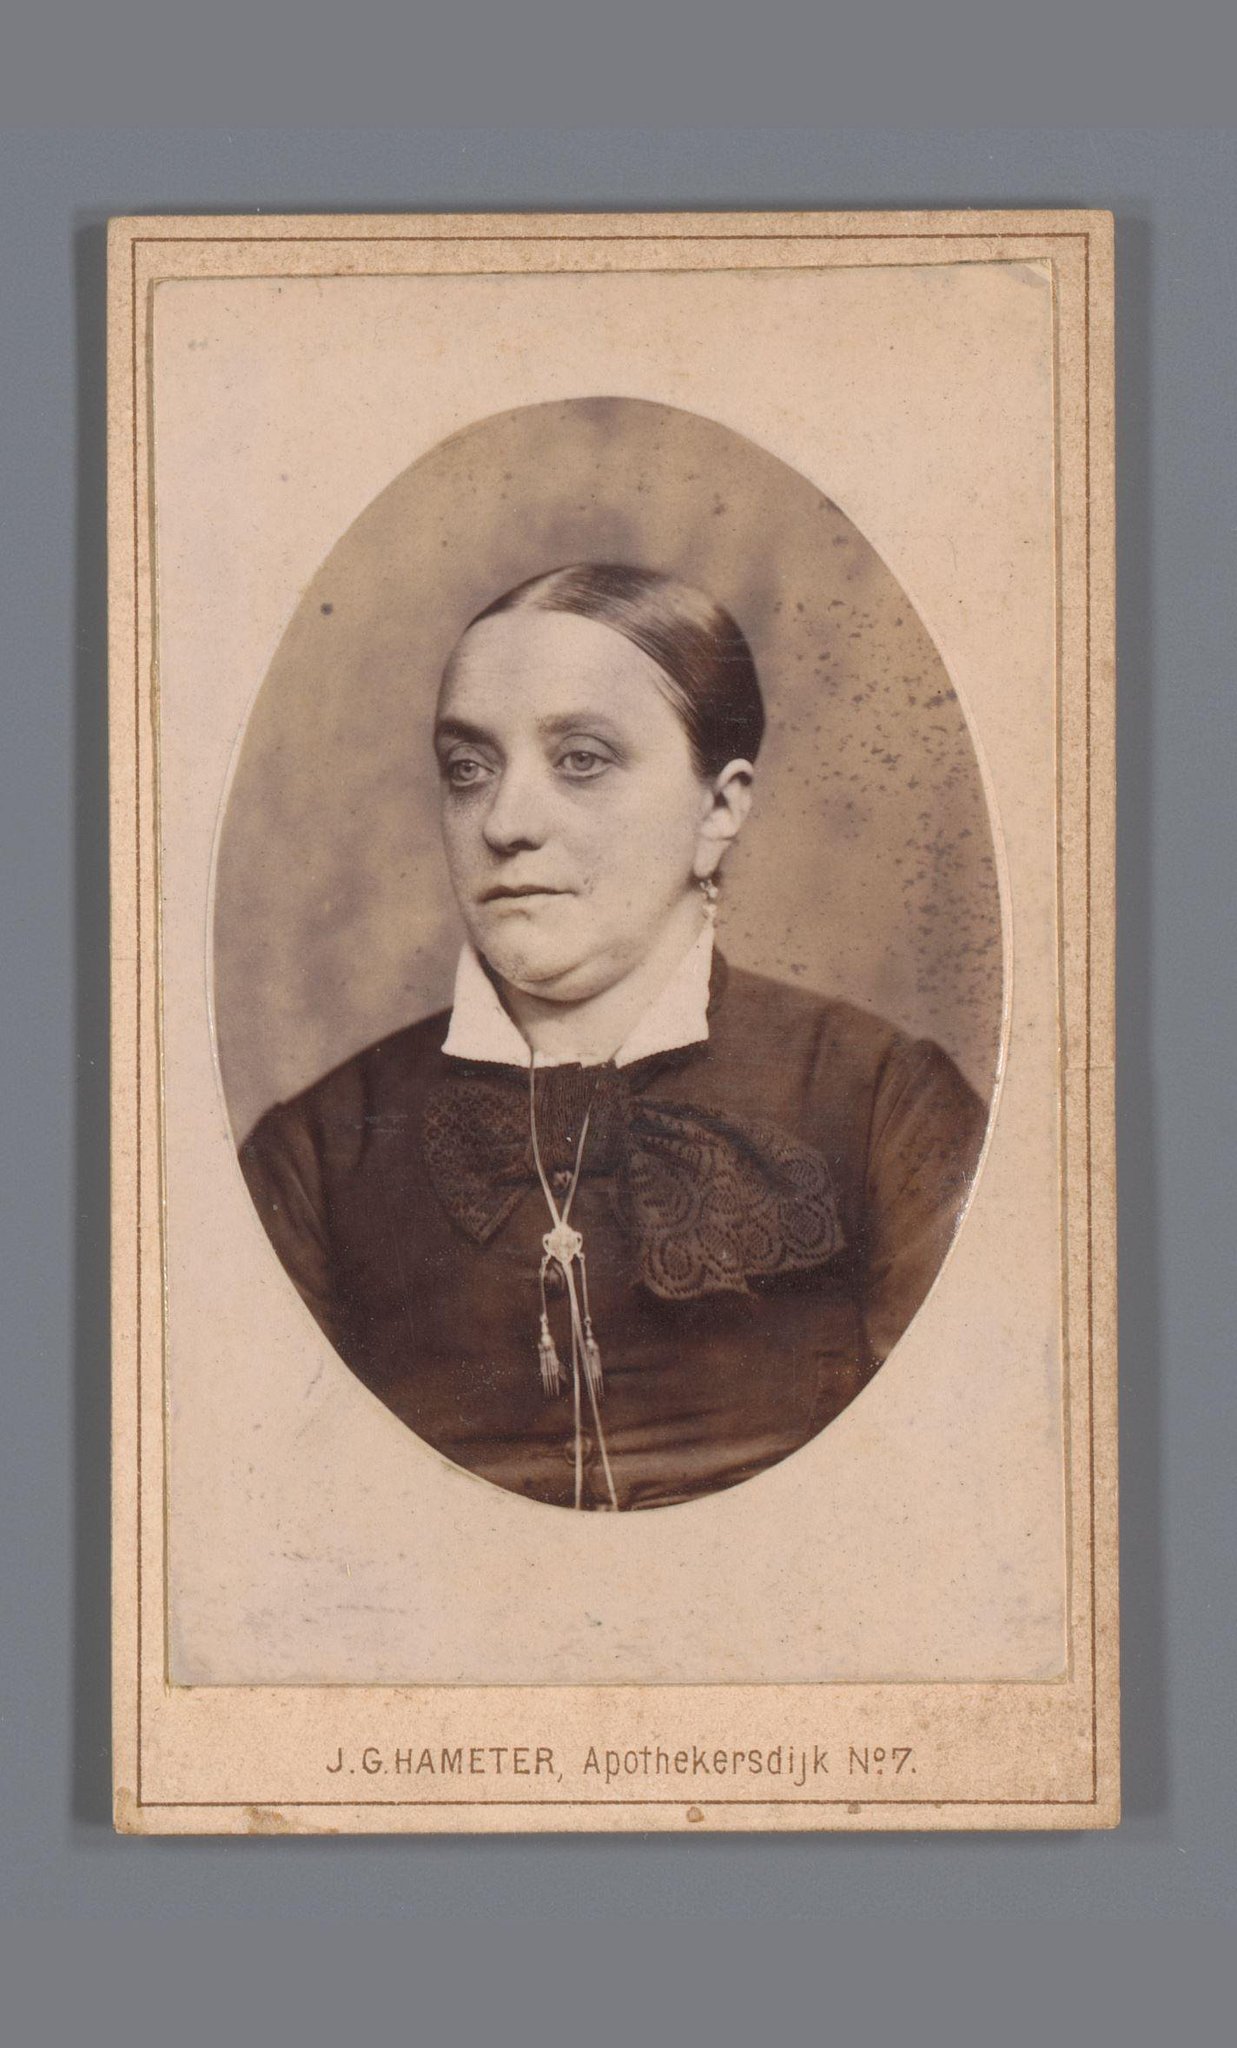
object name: carte de visite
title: Portret van een onbekende vrouw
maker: johann georg hameter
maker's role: fotograaf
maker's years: 1838-1885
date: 1879-1885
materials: cardboard, celluloid, paper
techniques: albumen print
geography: leiden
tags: historical persons - bb - woman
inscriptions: inscription: ‘F. G. Hameter/ HOF-PHOTOGRAPHE/ van/ H.M. de Koningin der Nederlanden/ LEIDEN & DORDRECHT./ BEKROOND OP DE TENTOONSTELLING/ te Utrecht 1877,/ te Amsterdam 1878, te Arnhem 1879,/ te Leenwarden 1881 met de Zilveren Med./ Men gelieve bij nabestelling bovenstaande nummer optegeven.’, address: ‘J. G. HAMETER, Apothekersdijk No. 7.’, number: ‘540’